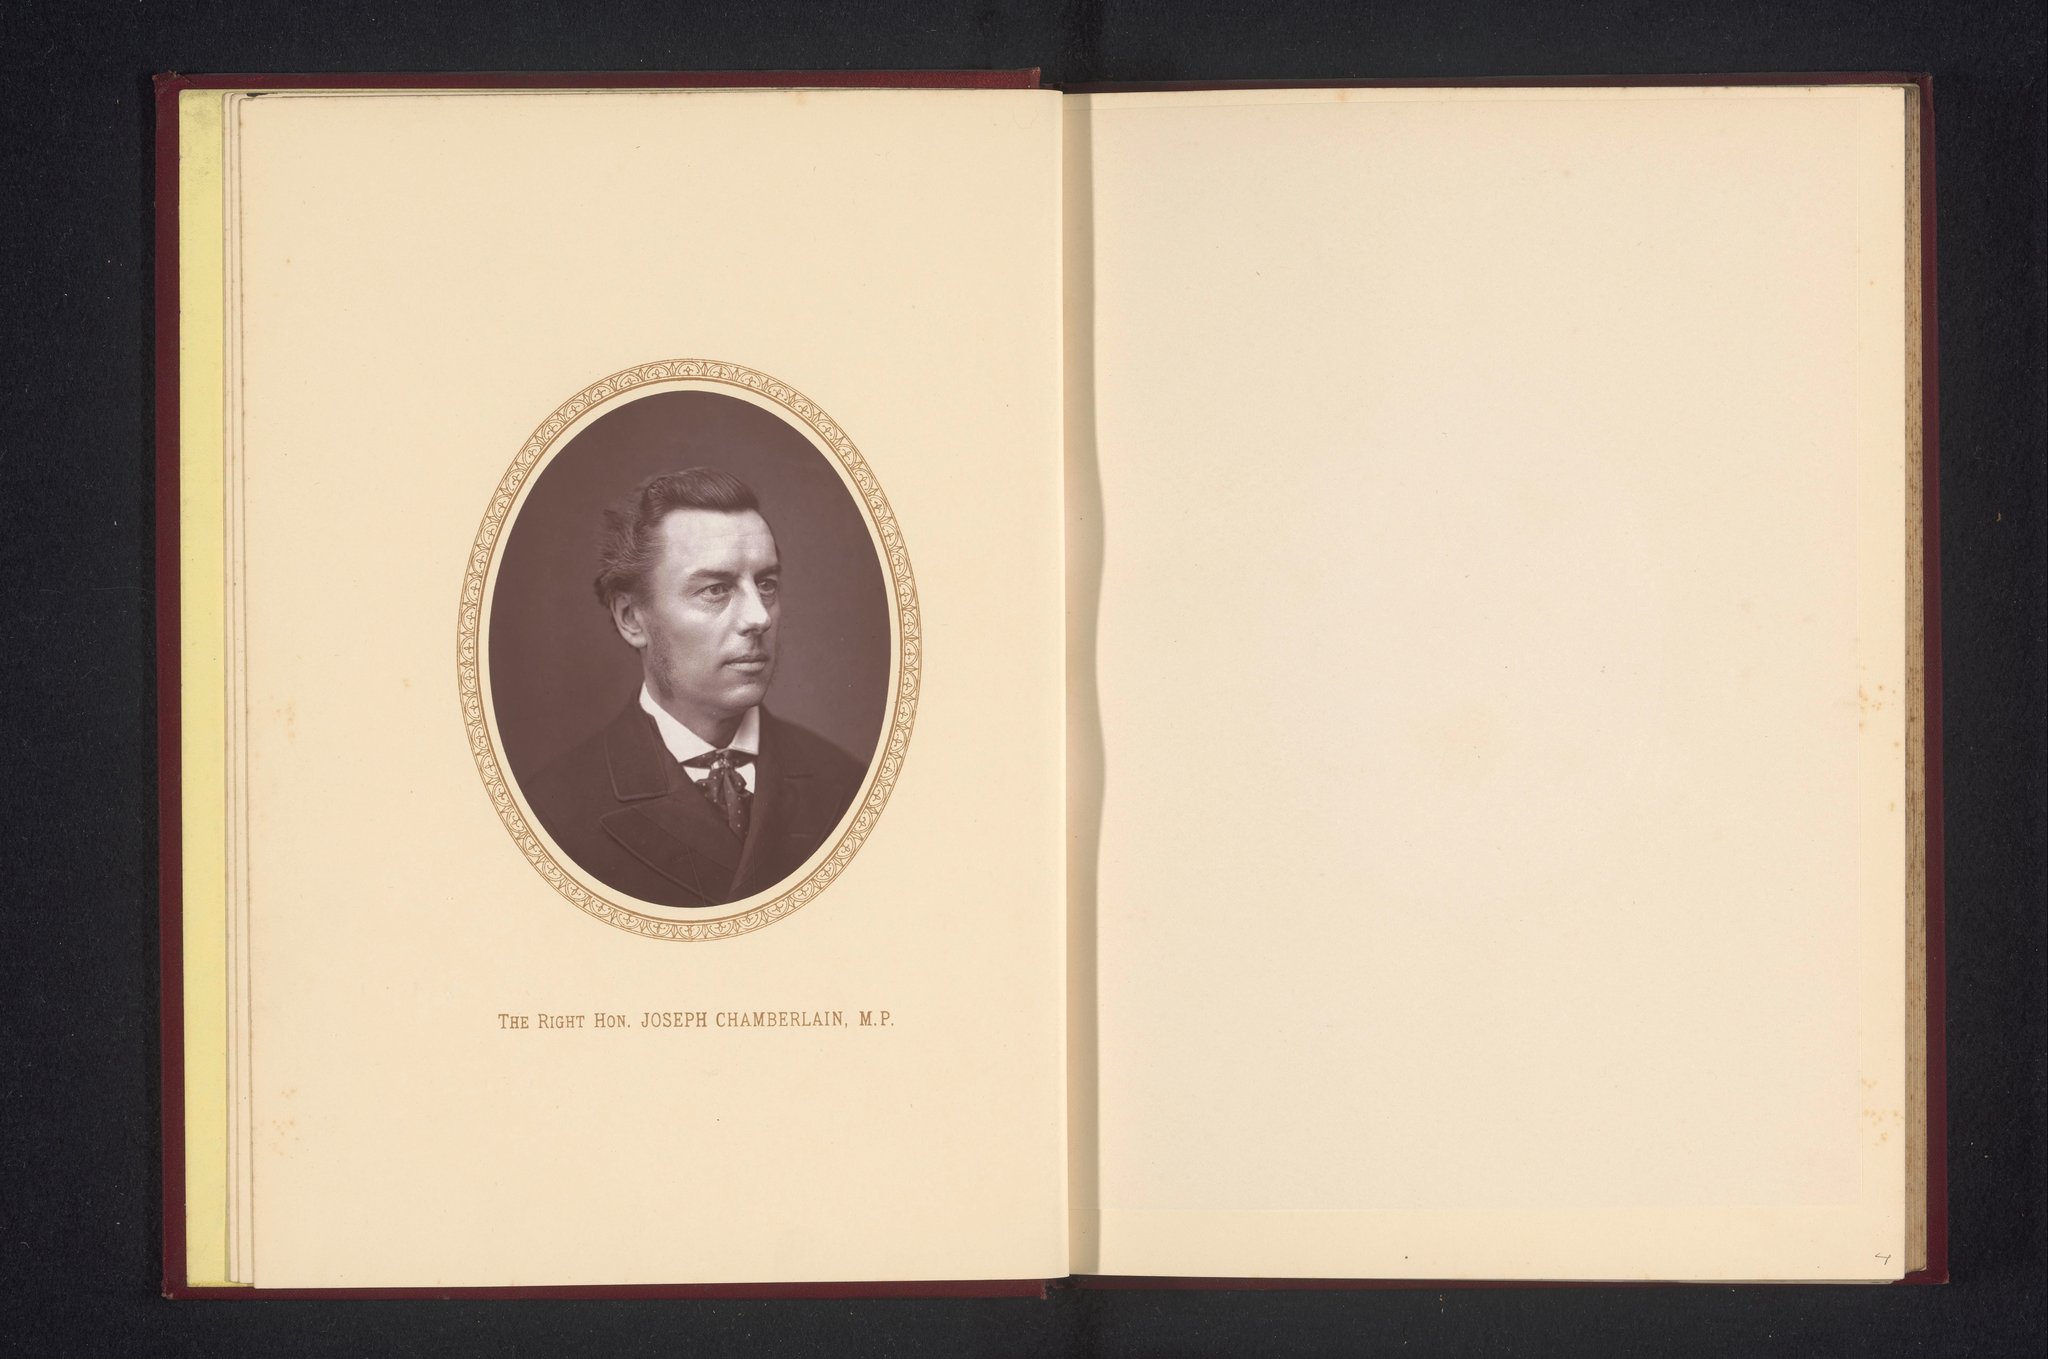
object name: page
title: The right hon. Joseph Chamberlain, M.P.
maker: Anonymous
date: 1875-1880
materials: paper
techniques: woodburytype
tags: politician, politician, e.g. party leader